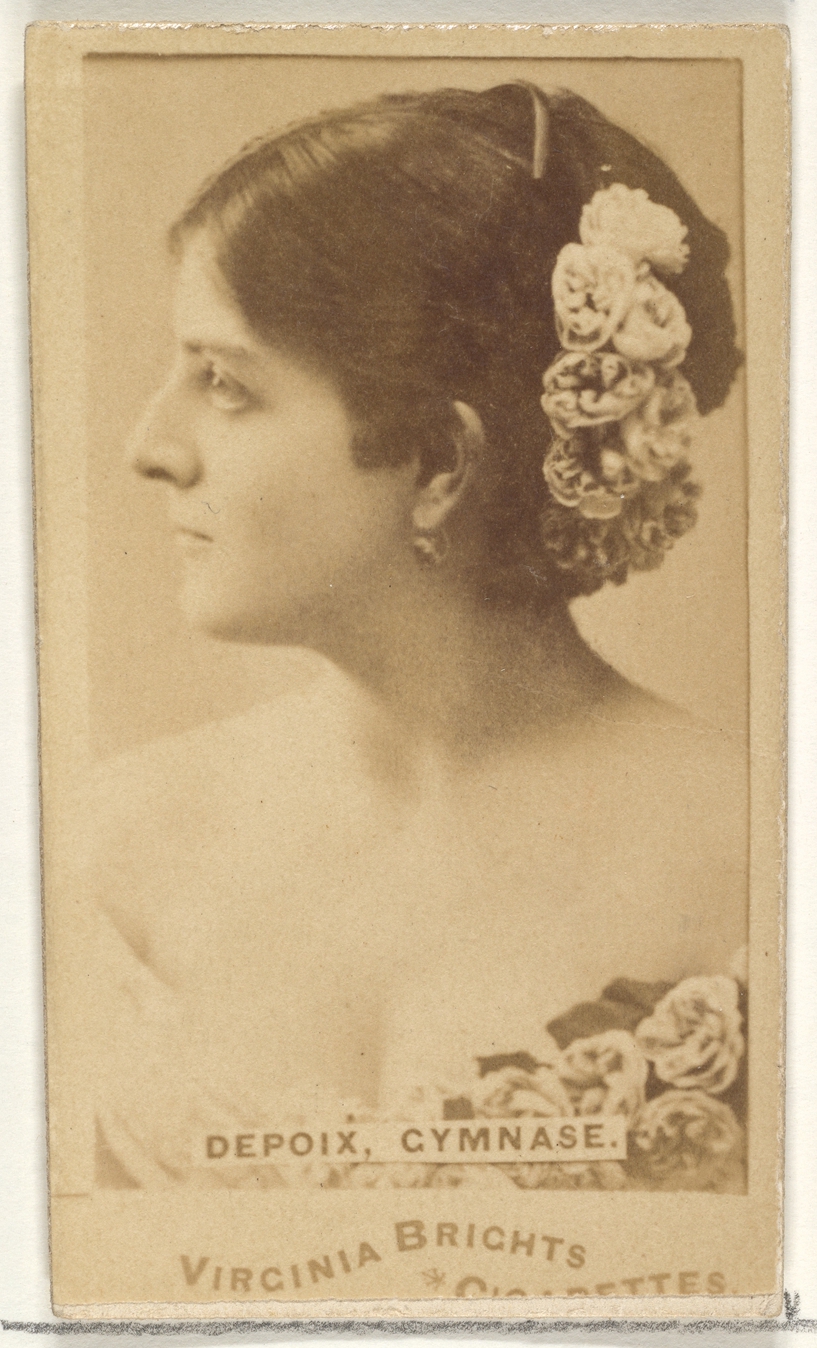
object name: photograph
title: Depoix, Gymnage, from the Actors and Actresses series (N45, Type 1) for Virginia Brights Cigarettes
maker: allen & ginter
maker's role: publisher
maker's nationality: american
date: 1888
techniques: albumen silver print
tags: portraits,profiles,women,actresses